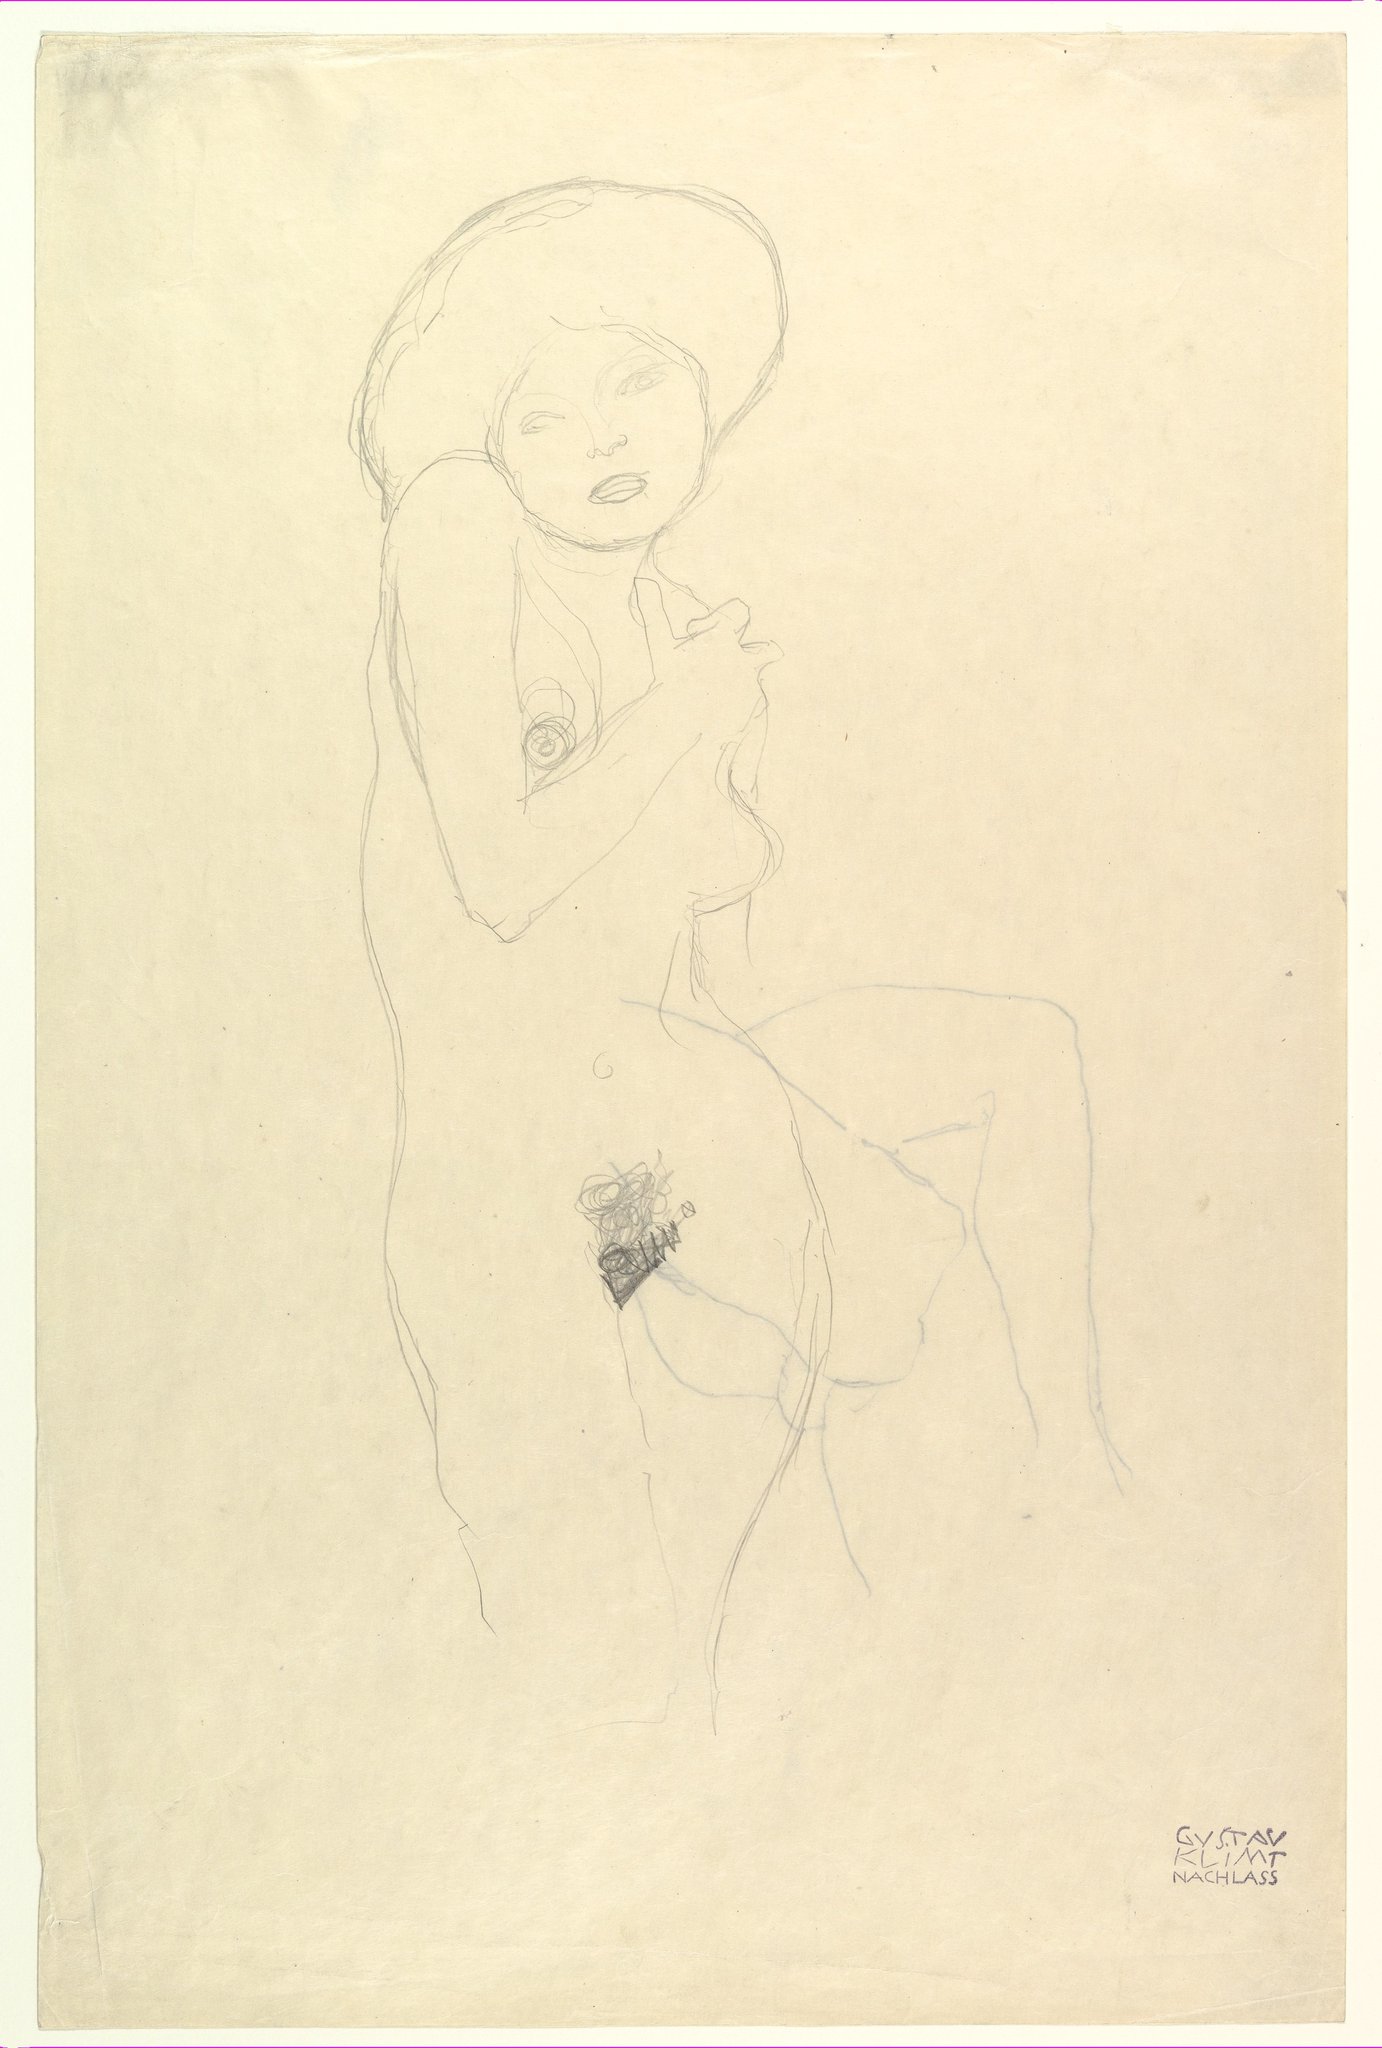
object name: drawing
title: Standing Nude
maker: gustav klimt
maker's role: artist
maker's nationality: austrian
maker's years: 1862-1918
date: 1906-1907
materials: graphite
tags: female nudes